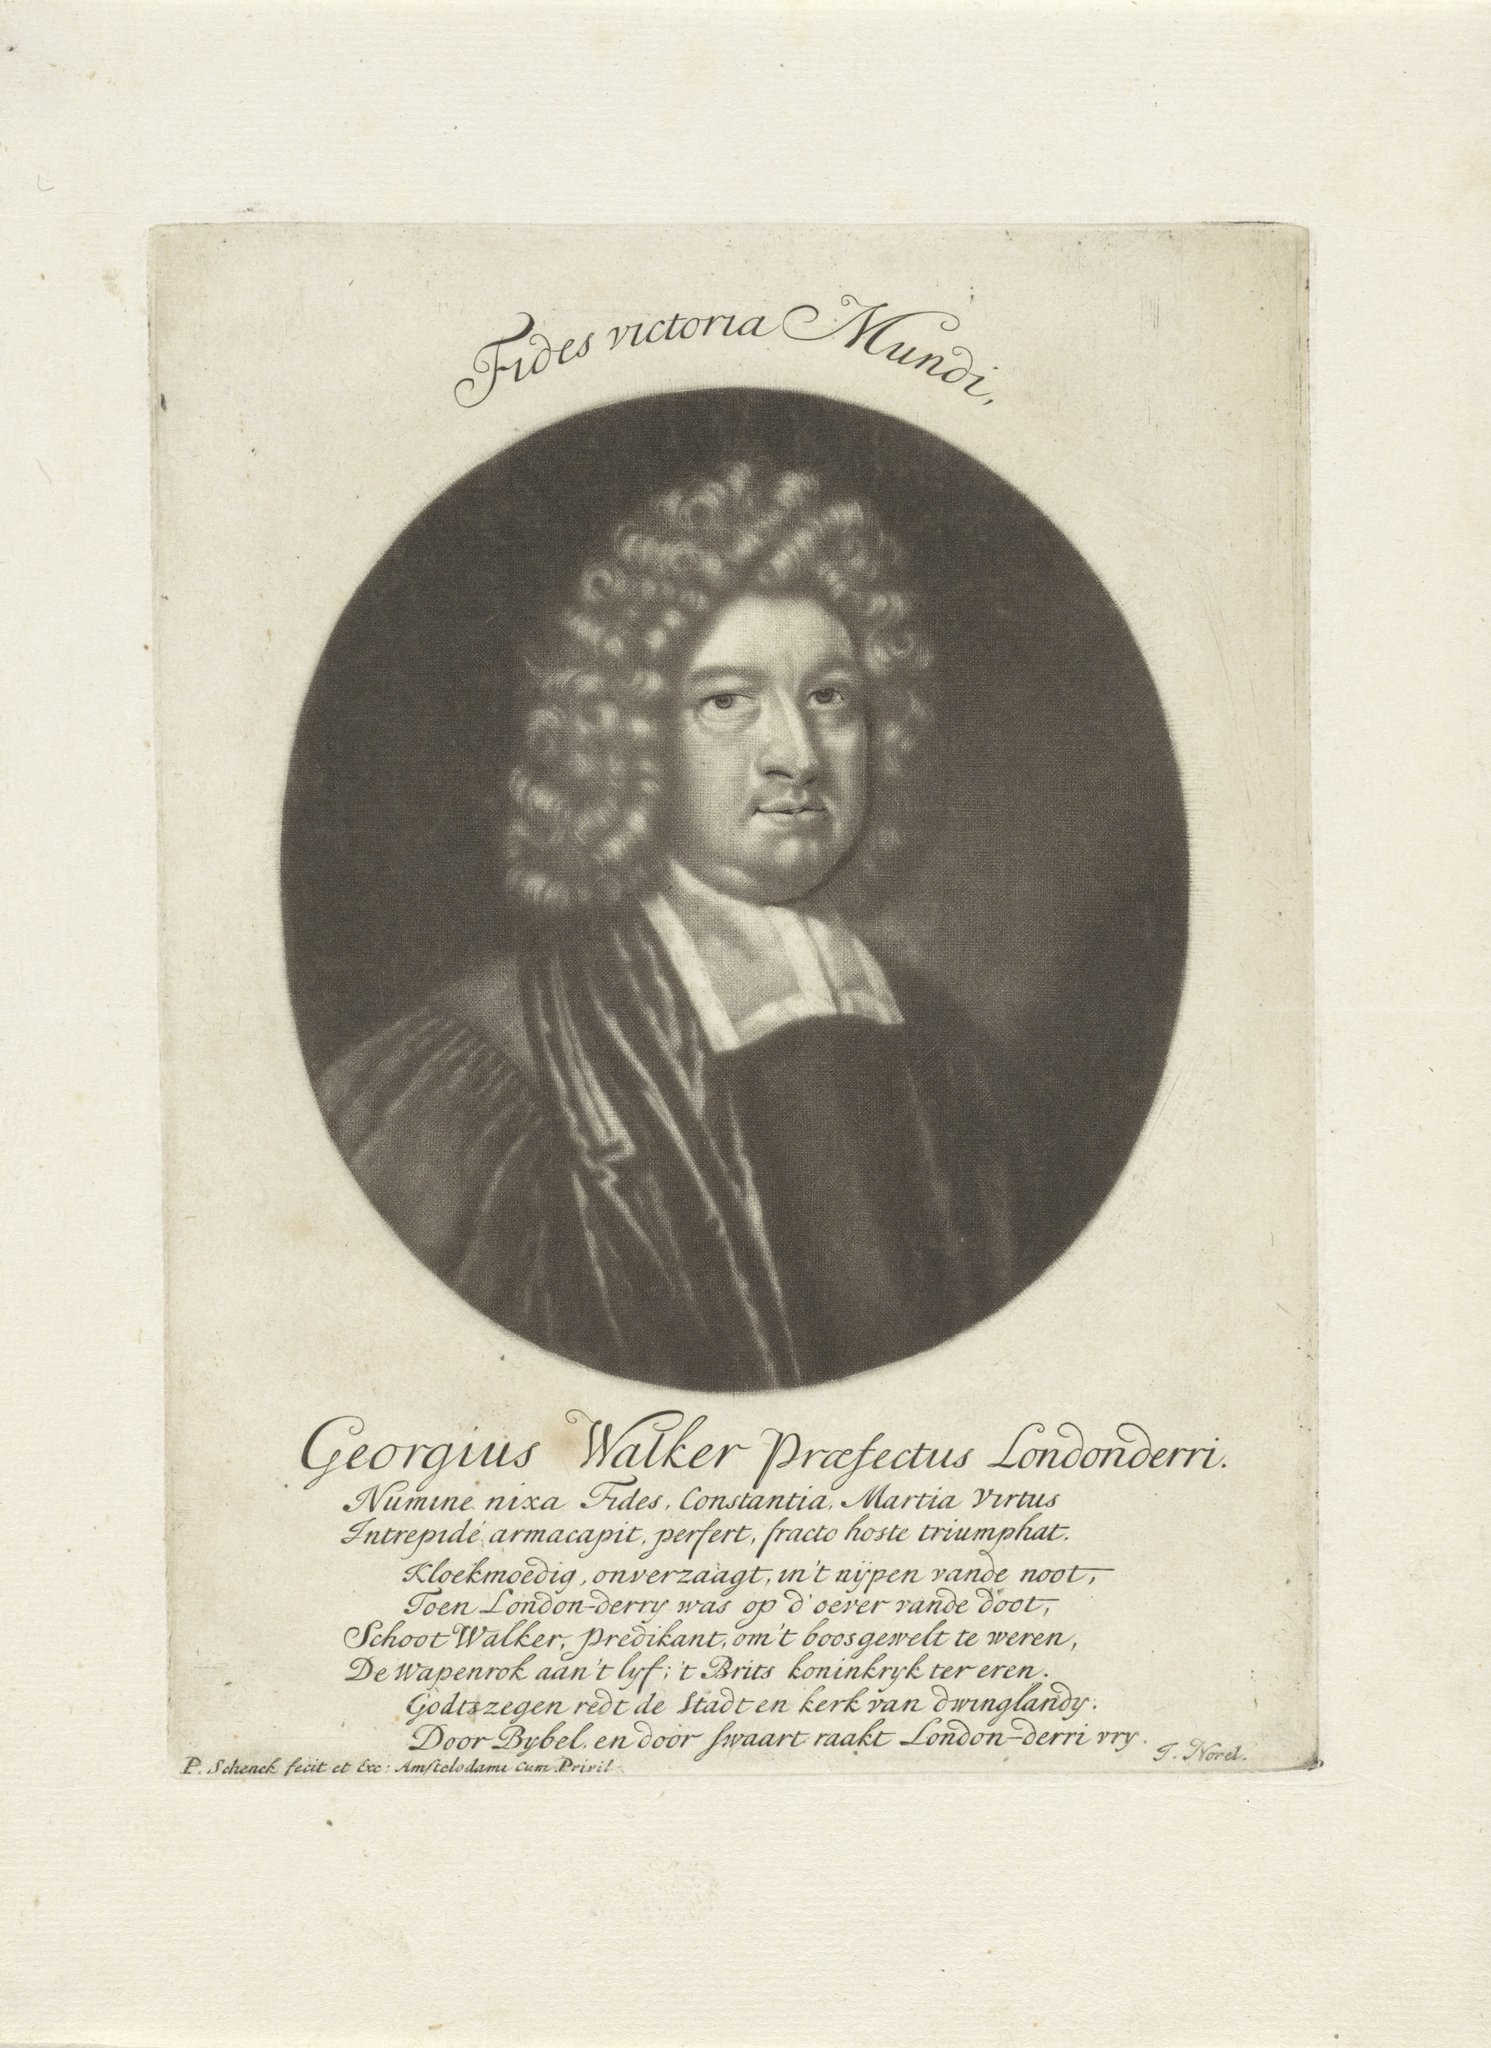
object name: print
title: Portret van George Walker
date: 1670-1713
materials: paper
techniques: engraving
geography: amsterdam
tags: george walker, wig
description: Portret van de Ierse Anglicaanse geestelijke George Walker in ambtskleding. In de marge een vers over het heldhaftige optreden van de geportretteerde als gouverneur tijdens de oorlog van Londonderry (huidige Derry).